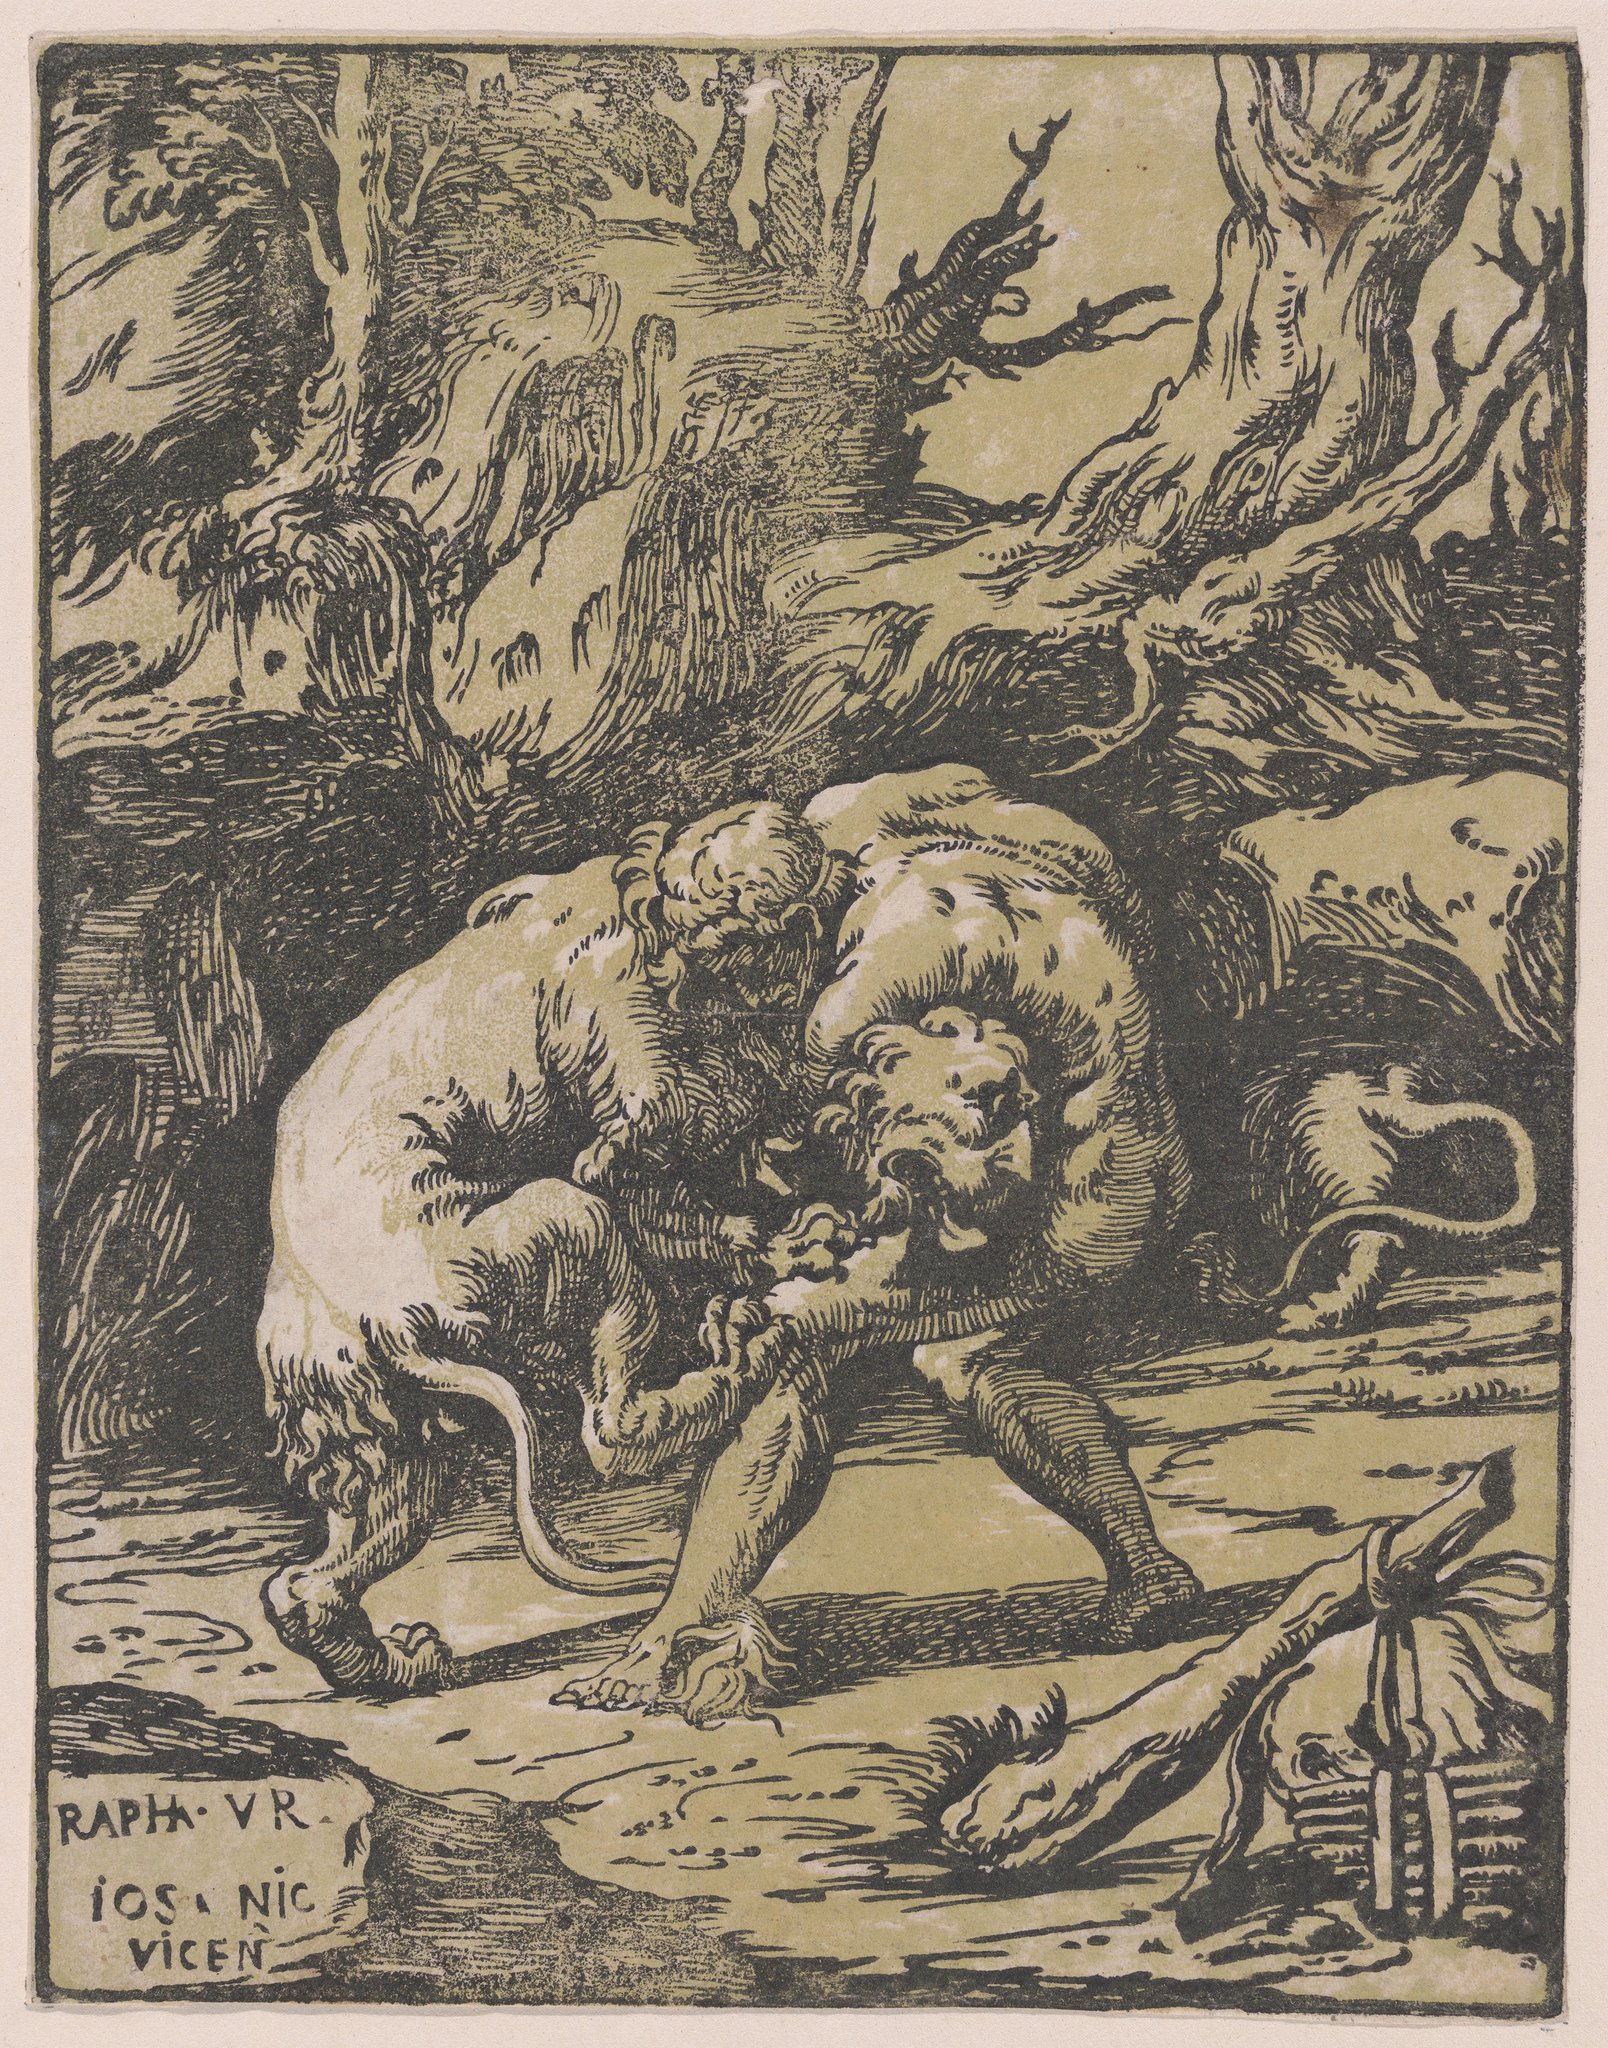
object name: print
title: Hercules and the Nemean Lion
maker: niccolò vicentino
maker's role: artist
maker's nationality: italian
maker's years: 1510-1550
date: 1540-1550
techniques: woodcut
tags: hercules,monsters,lions